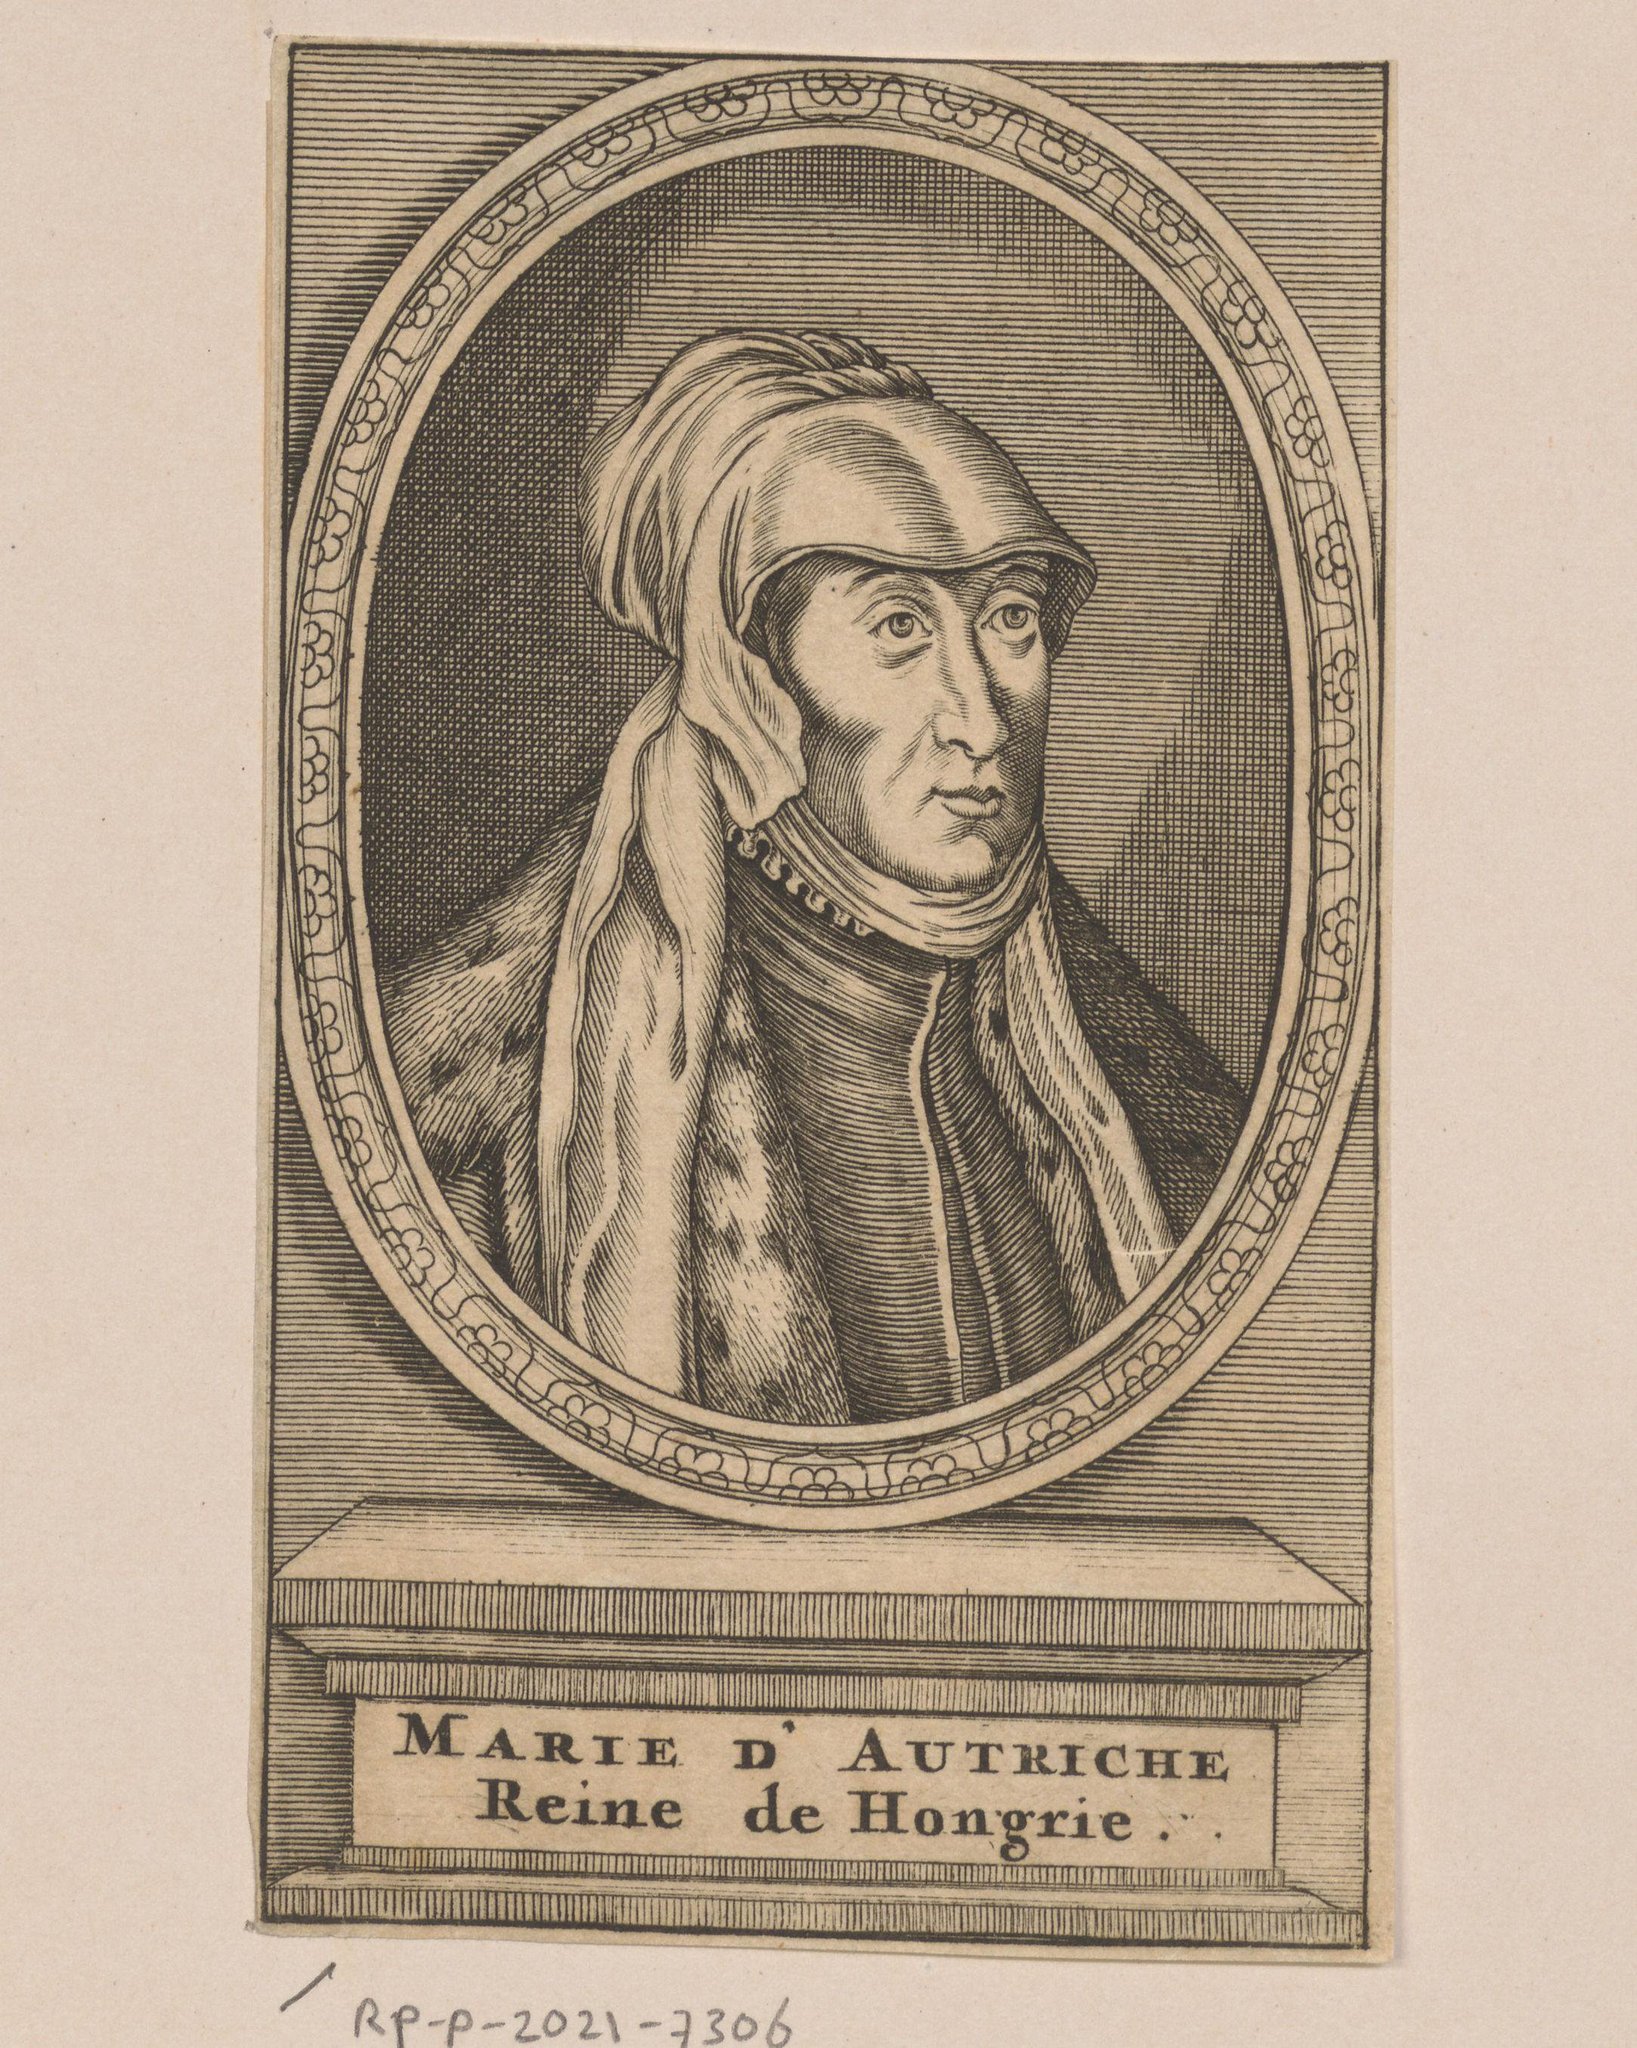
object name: print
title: Portret van Maria van Hongarije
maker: Anonymous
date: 1670-1750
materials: paper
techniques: engraving, etching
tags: brussels, maria van hongarije (landvoogdes der nederlanden), historical persons - bb - woman, ornament ~ medallion, regent, substitute ruler; viceroy - bb - female ruler